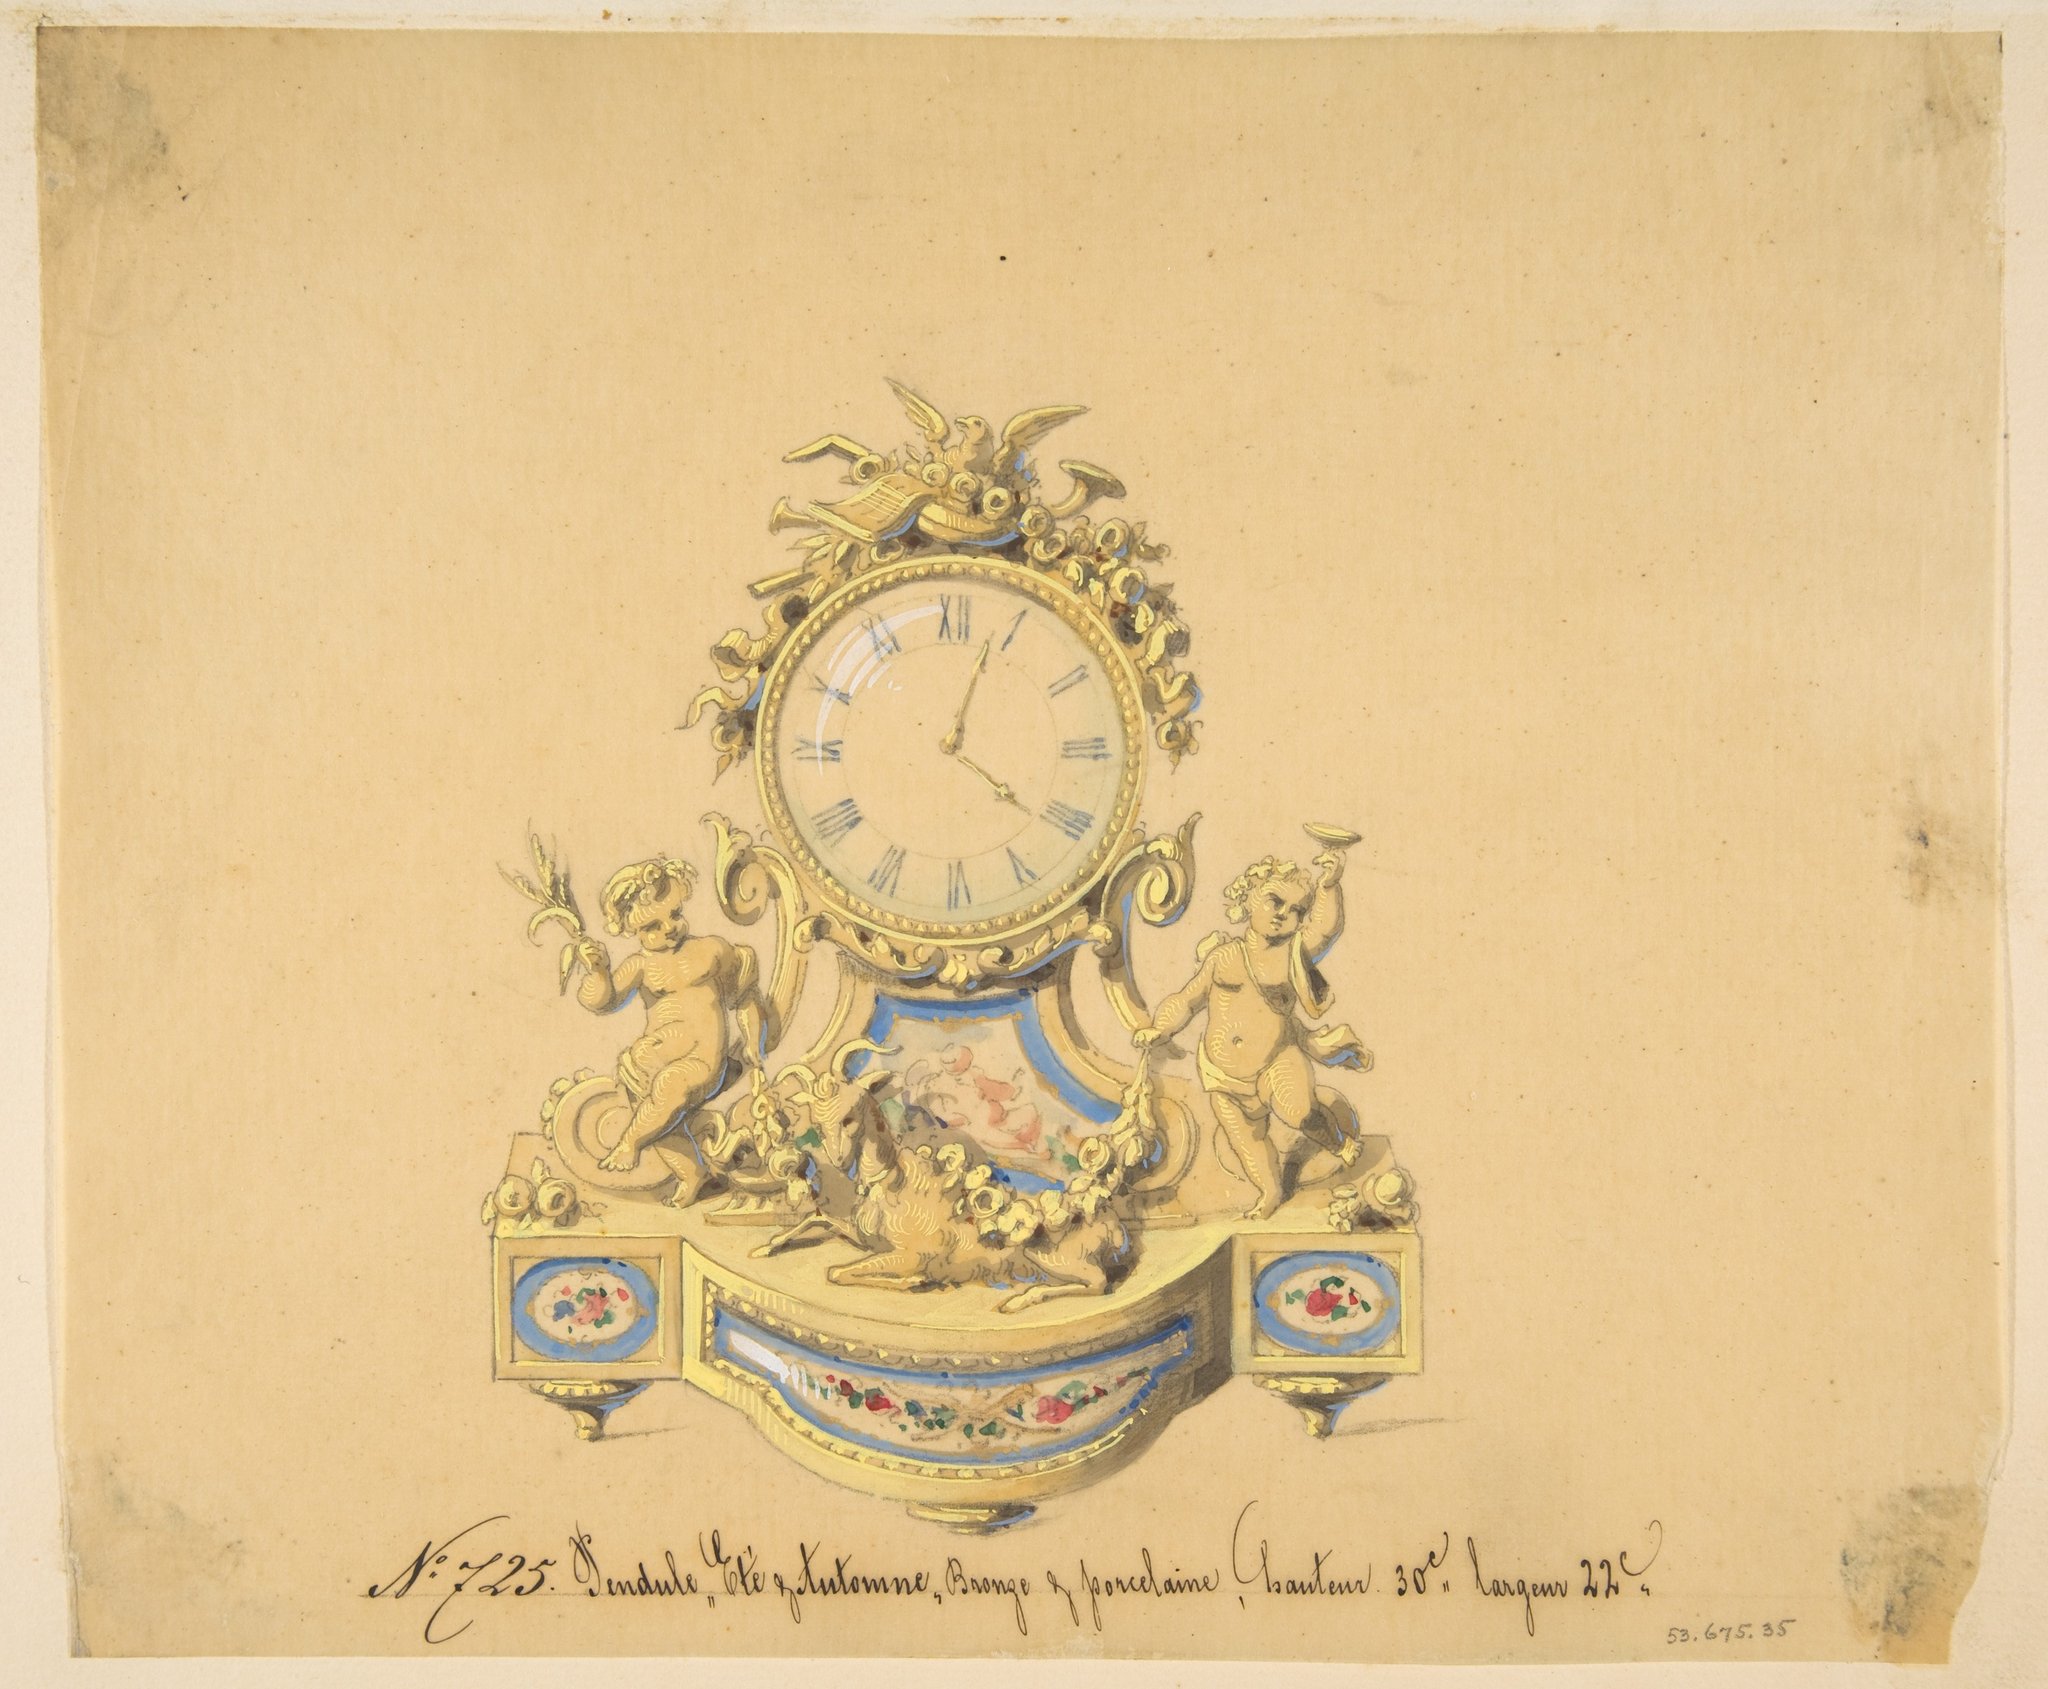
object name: drawing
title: Design for a Clock: Summer and Autumn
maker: anonymous, french, 19th century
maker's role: artist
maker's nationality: french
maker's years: 1800-1900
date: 1801-1900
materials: gouache, graphite, ink, watercolor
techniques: brush, pen, wash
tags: goats,clocks